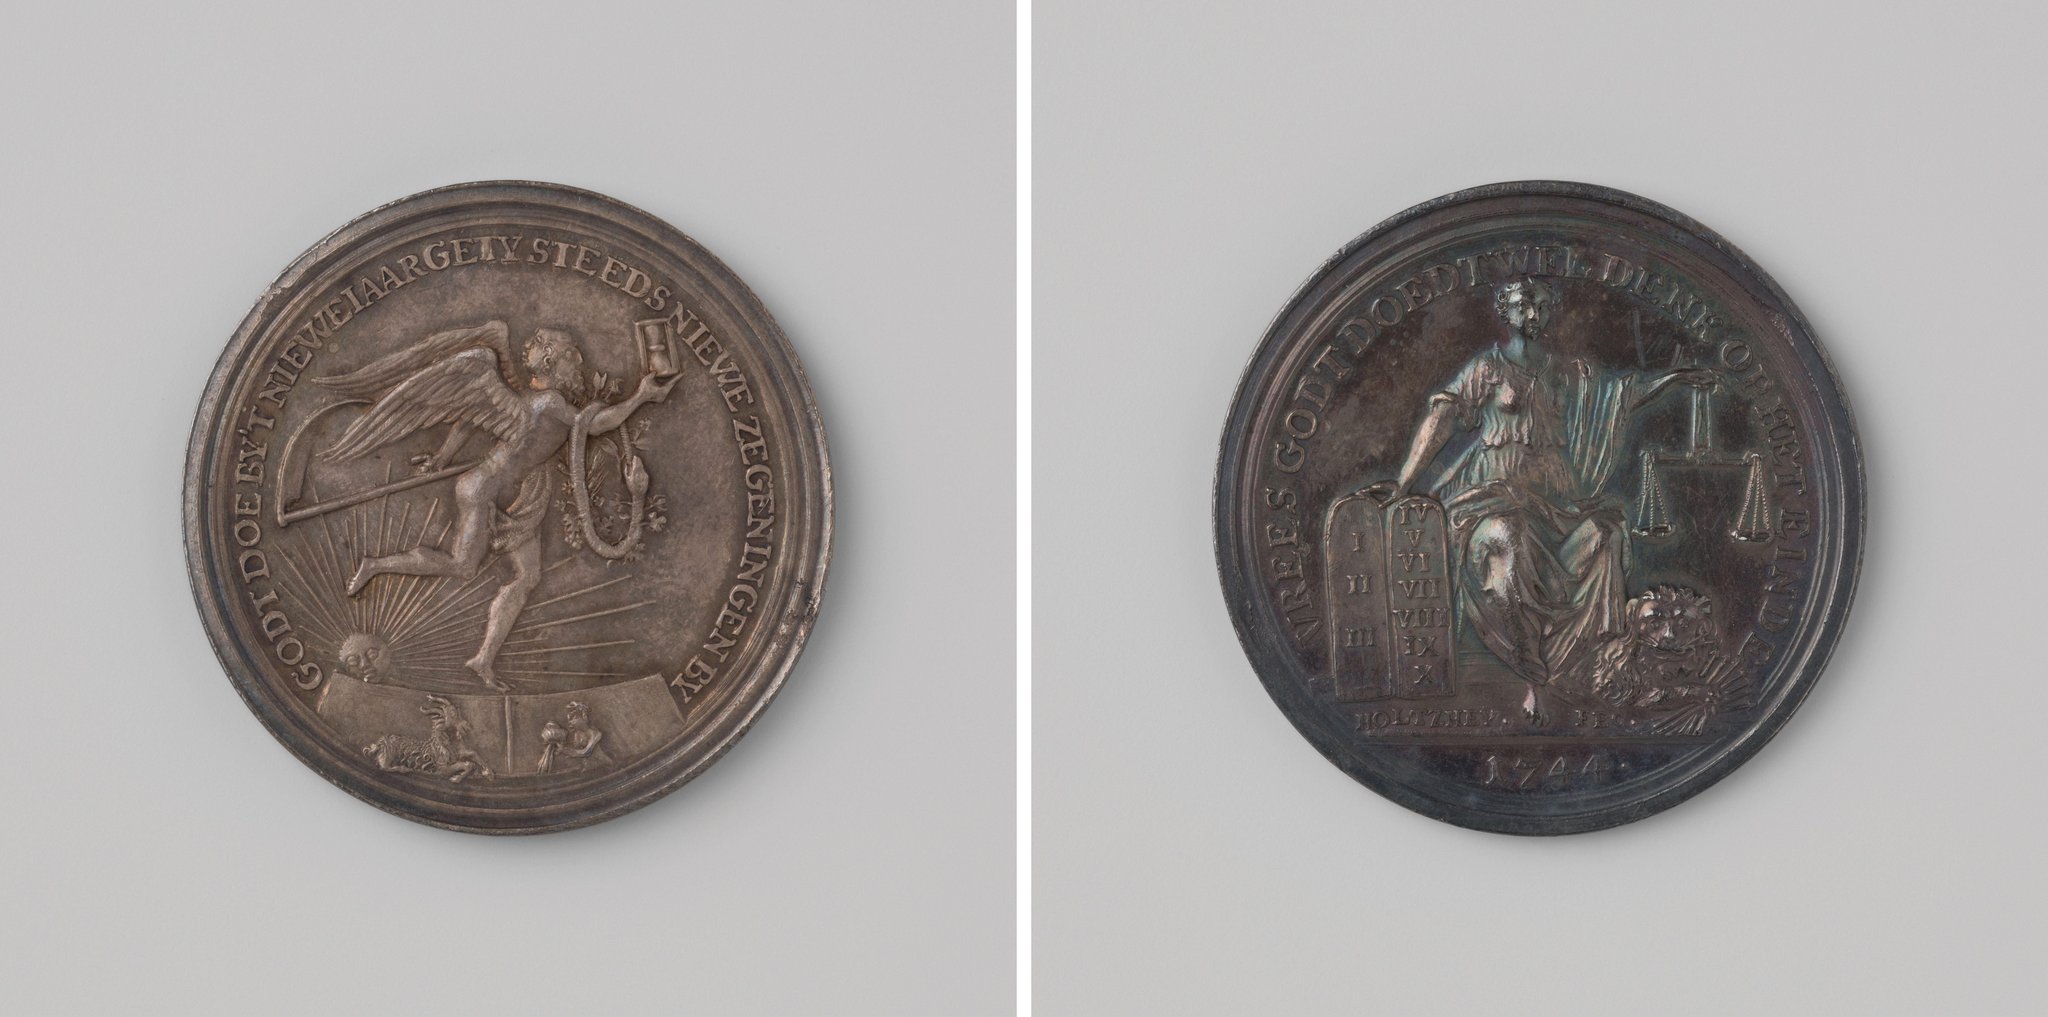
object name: new year medal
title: Aanvang van het jaar 1744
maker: martinus holtzhey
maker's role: medailleur, muntmaker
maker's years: 1697-1764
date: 1743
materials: silver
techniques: striking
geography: amsterdam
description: Zilveren penning. Voorzijde: Tijd met zandloper, zeis en slangerond omwonden met bladerloof, staande op dierenriem, beschenen door opgaande zon binnen omschrift. Keerzijde: Nederlandse maagd, vergezeld door leeuw met pijlenbundel, houdt weegschaal en geopend boek in handen binnen omschrift; afsnede: jaartal